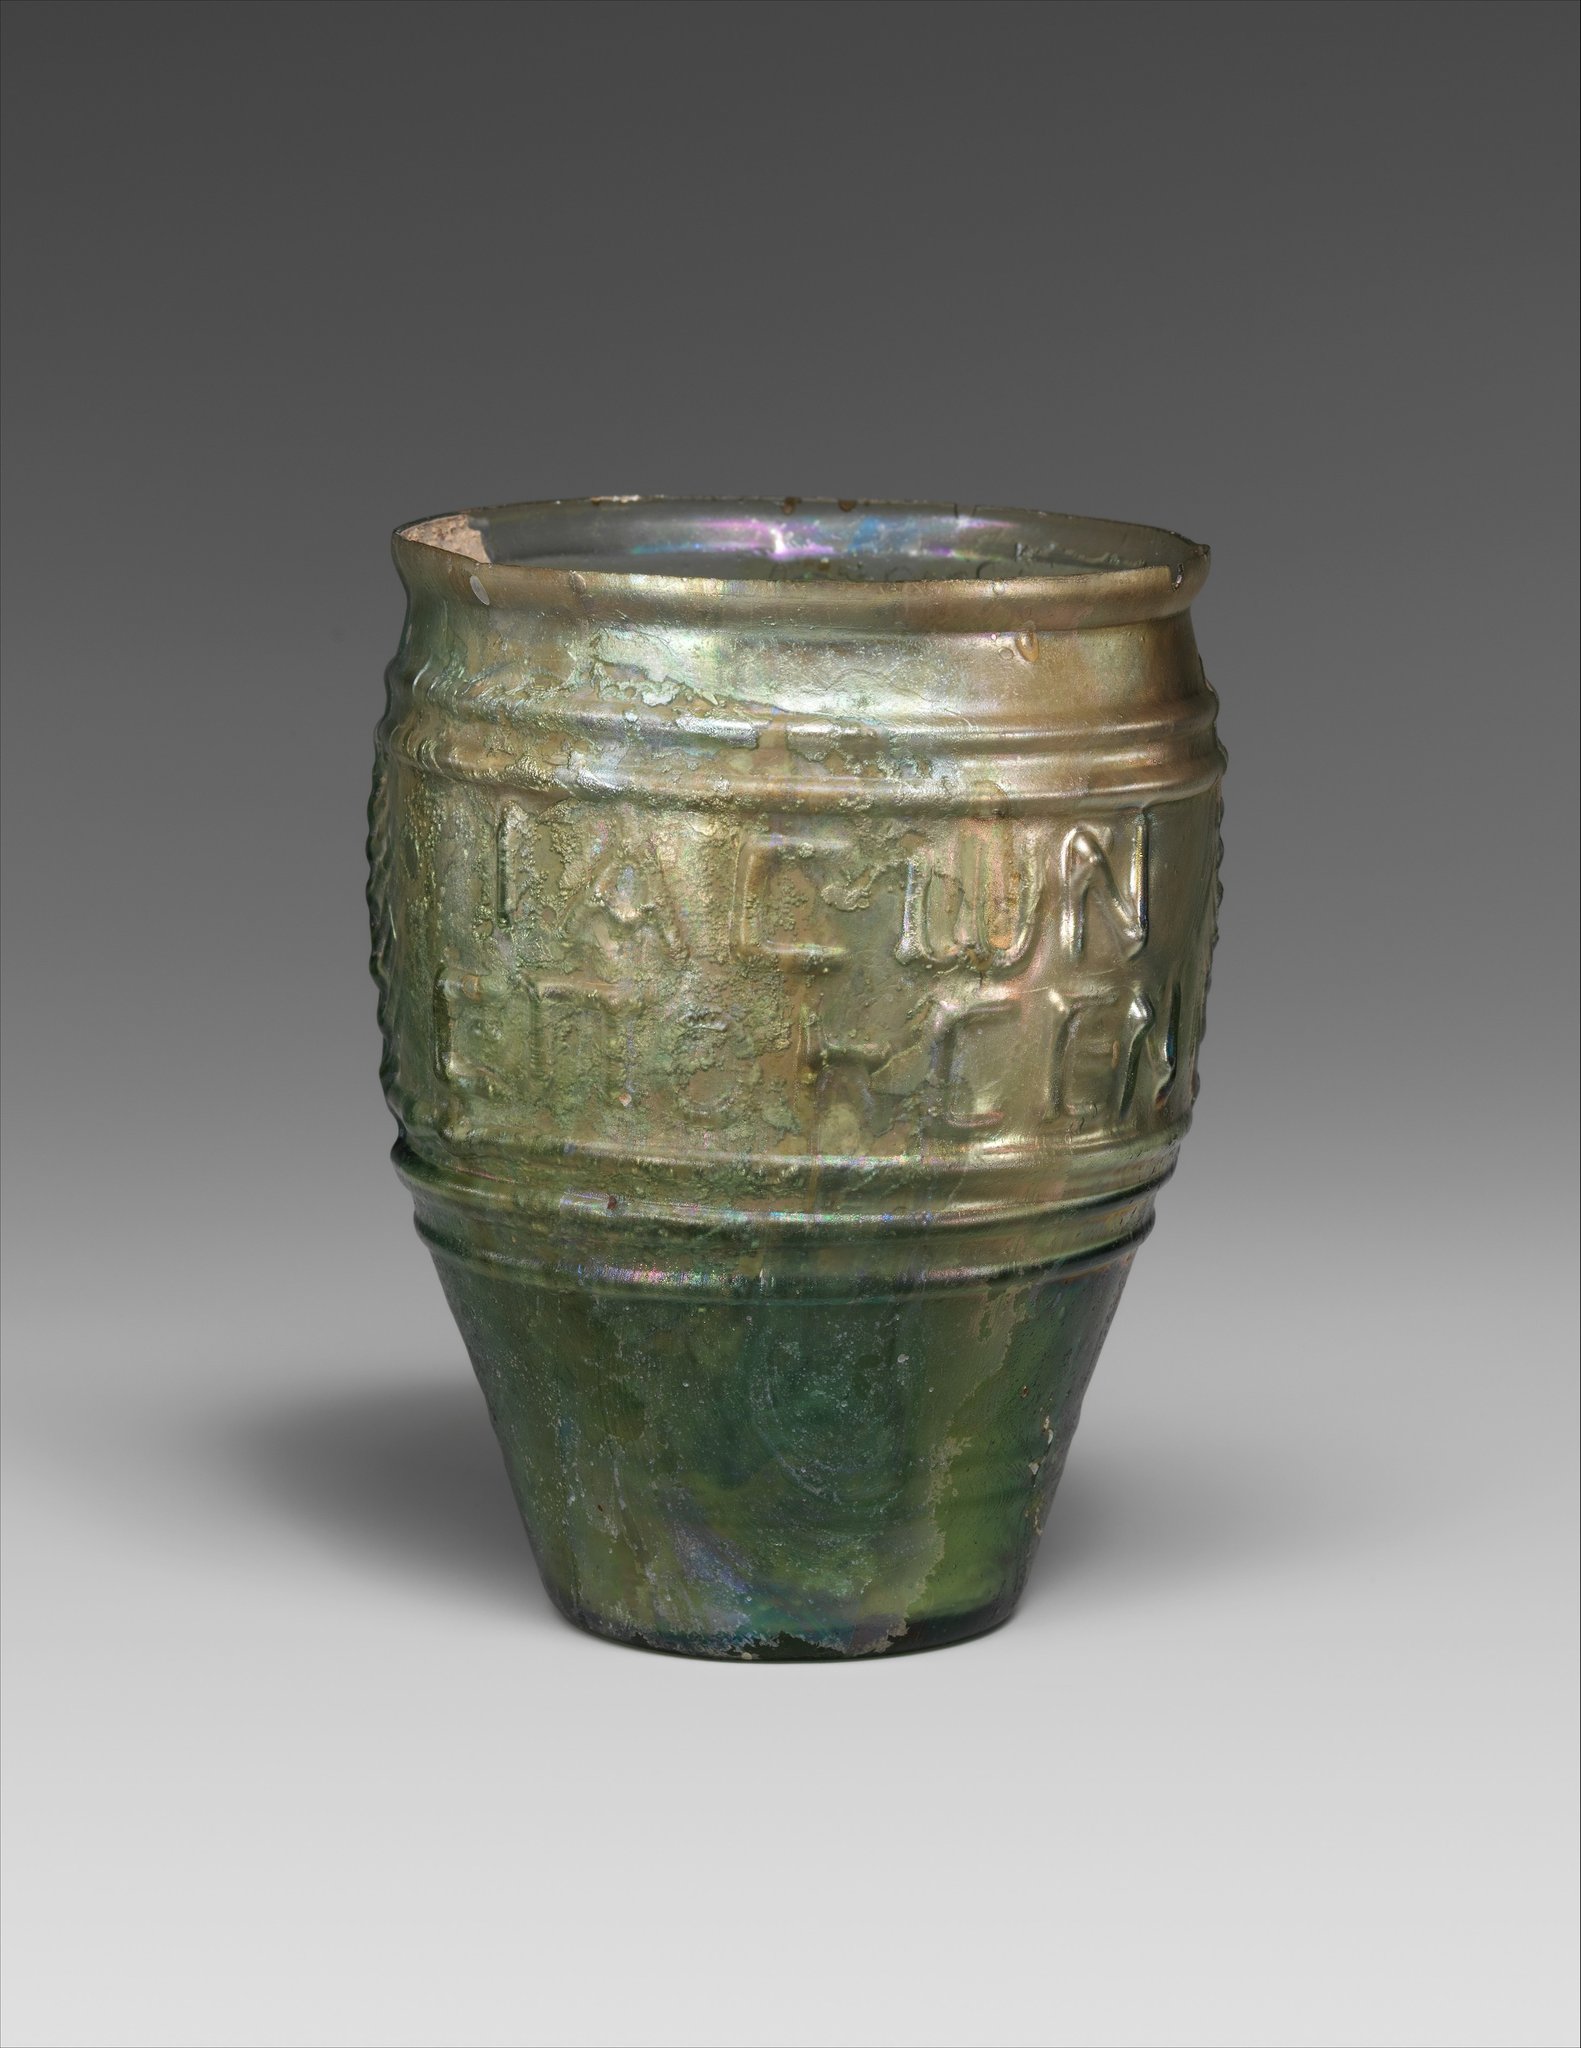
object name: beaker signed by jason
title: Glass beaker signed by Jason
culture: roman, syro-palestinian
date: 34-66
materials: glass